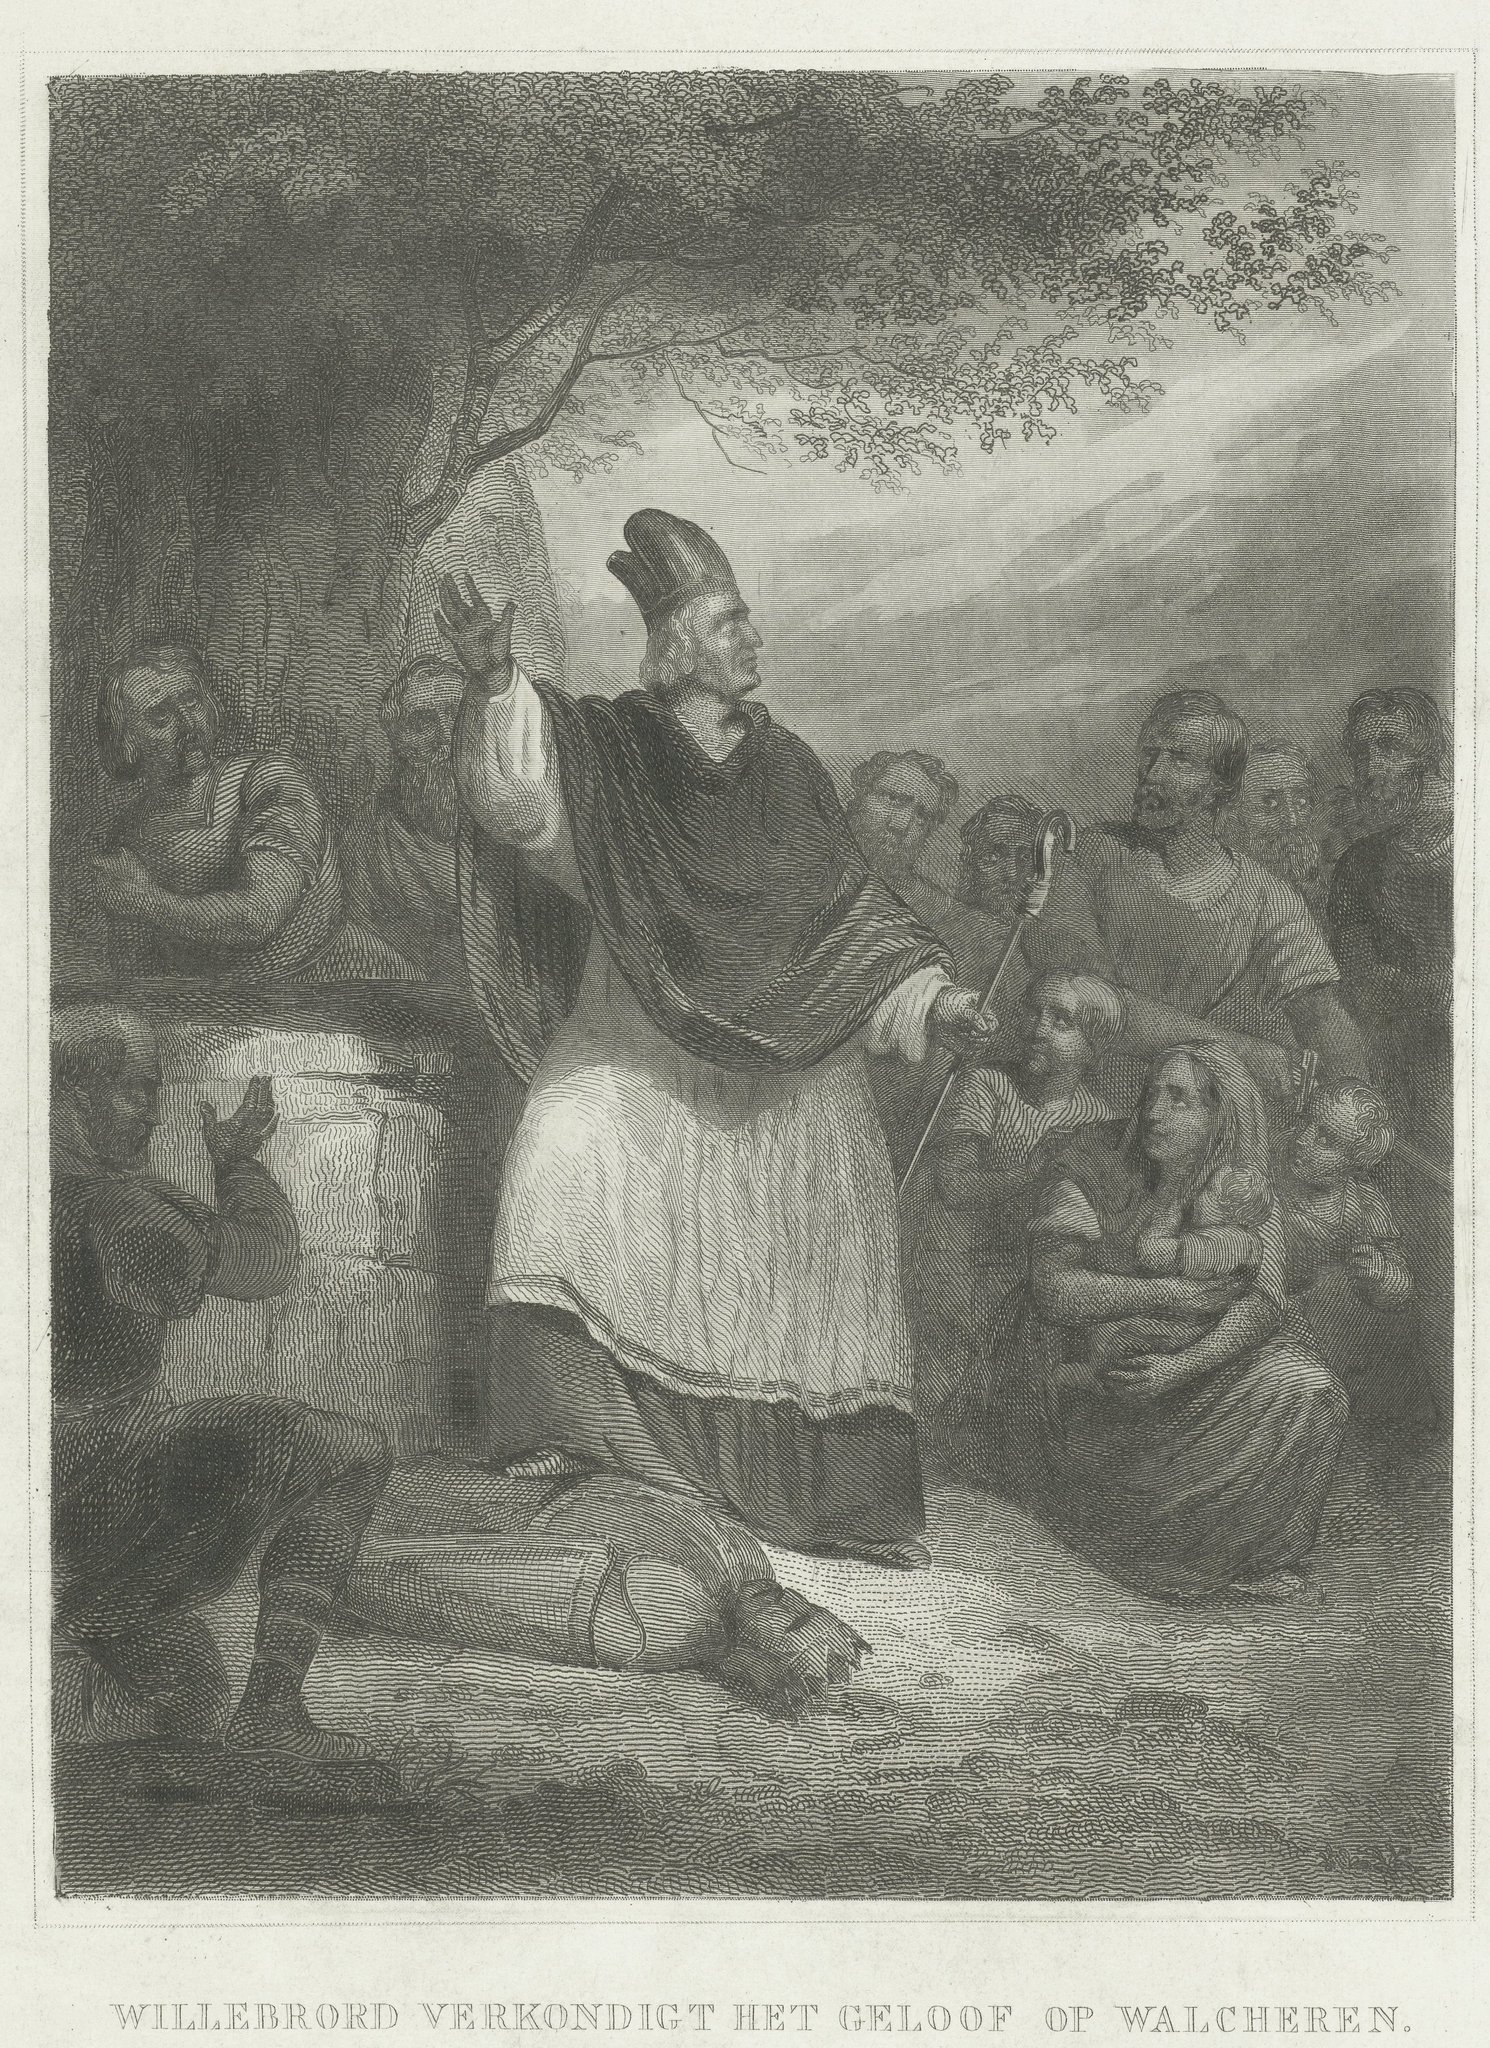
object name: history print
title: Willibrord verkondigt het geloof op Walcheren, 695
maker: johann wilhelm kaiser (i)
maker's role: draughtsman, print maker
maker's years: 1813-1900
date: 1840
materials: paper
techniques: engraving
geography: netherlands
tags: st. willibrord breaking the pagan idols, spreading the gospel; missionary work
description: De katholieke missionaris Willibrord verkondigt in 695 op Walcheren het Christendom, staande met een voet op een afgeworpen beeld van een niet-christelijke godheid.